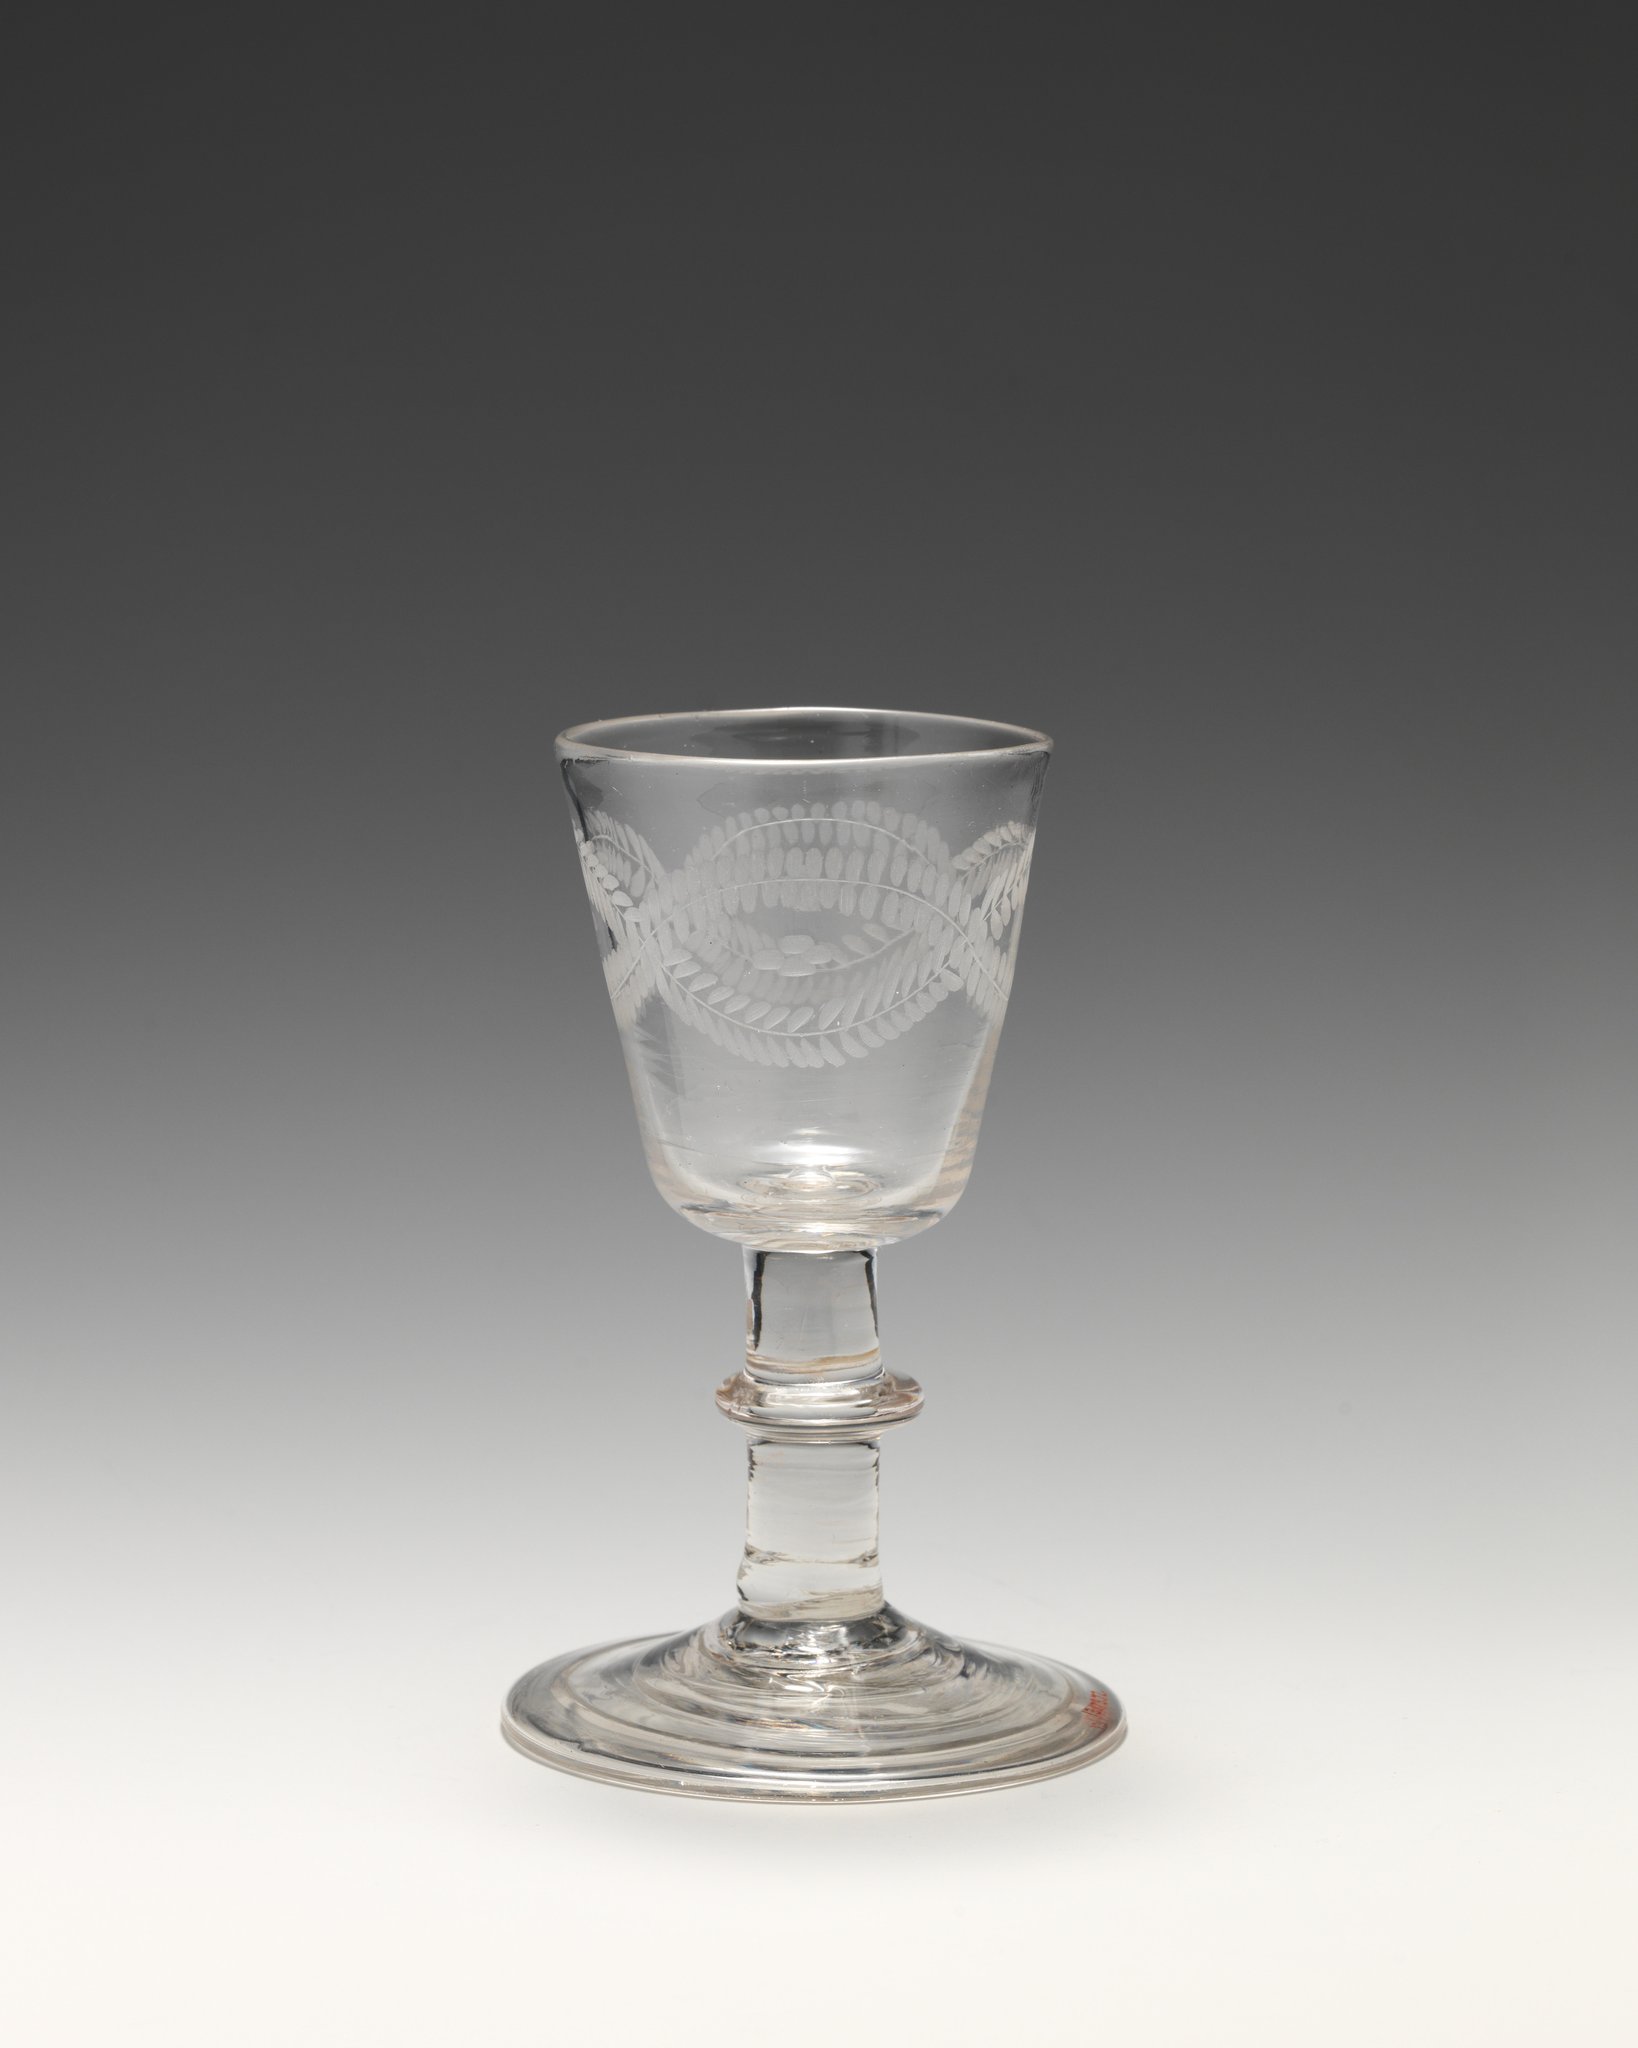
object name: wineglass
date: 1701-1800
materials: glass